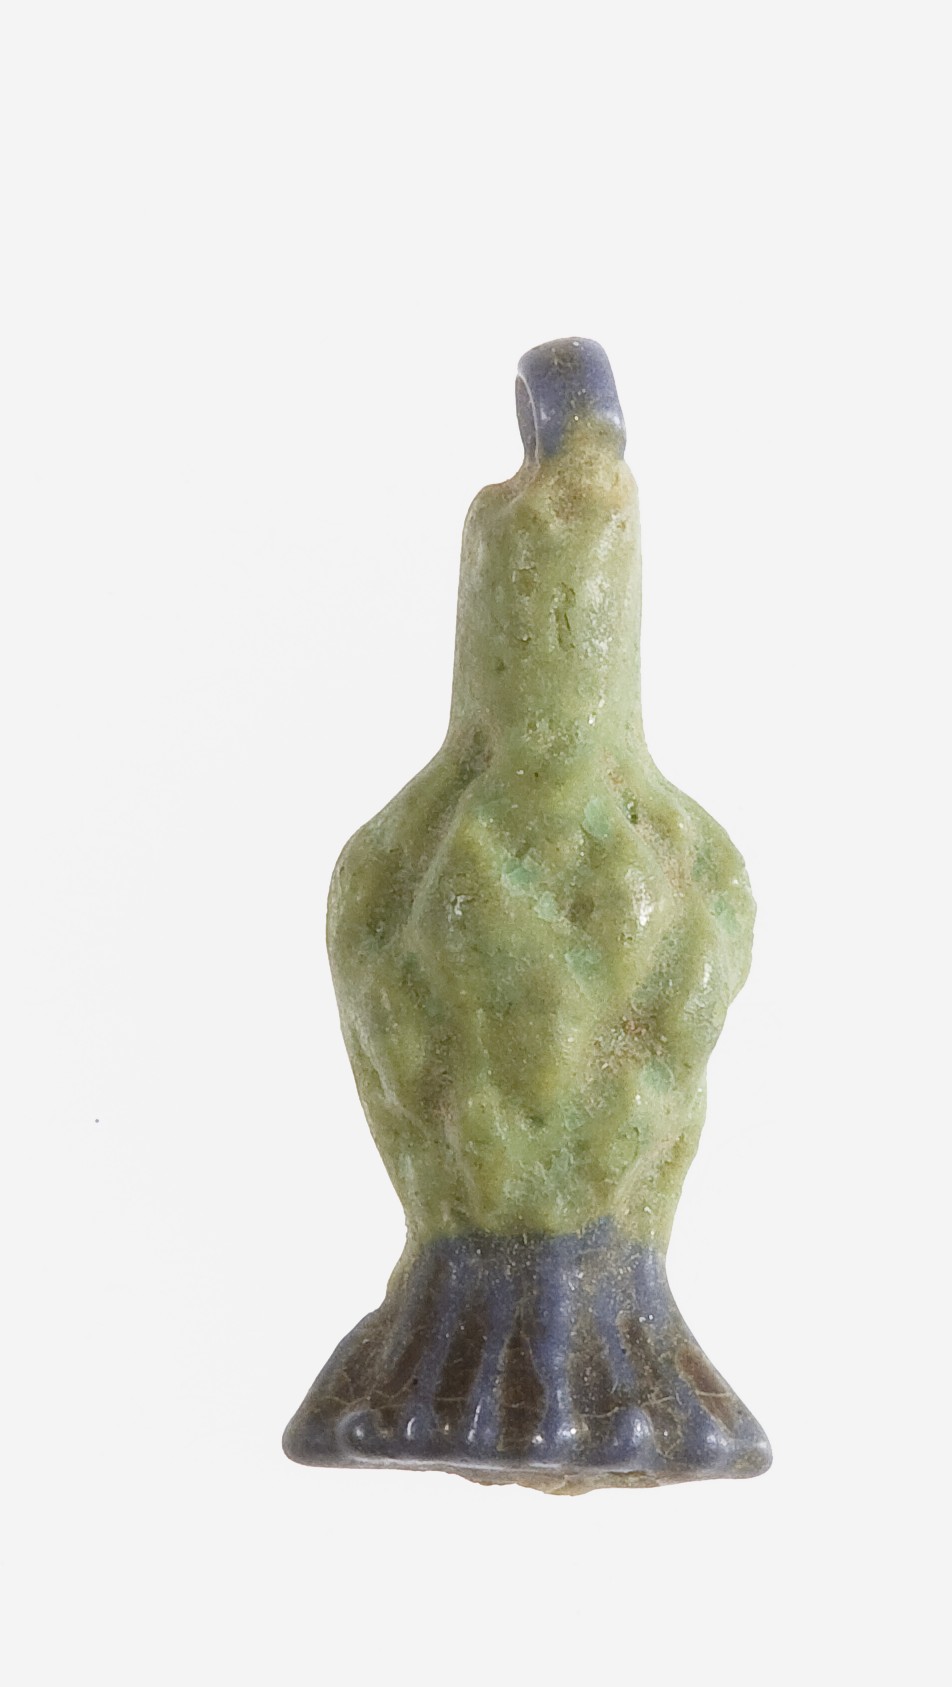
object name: pendant, cornflower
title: Cornflower Pendant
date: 1390-1352 BCE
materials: faience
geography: egypt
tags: flowers